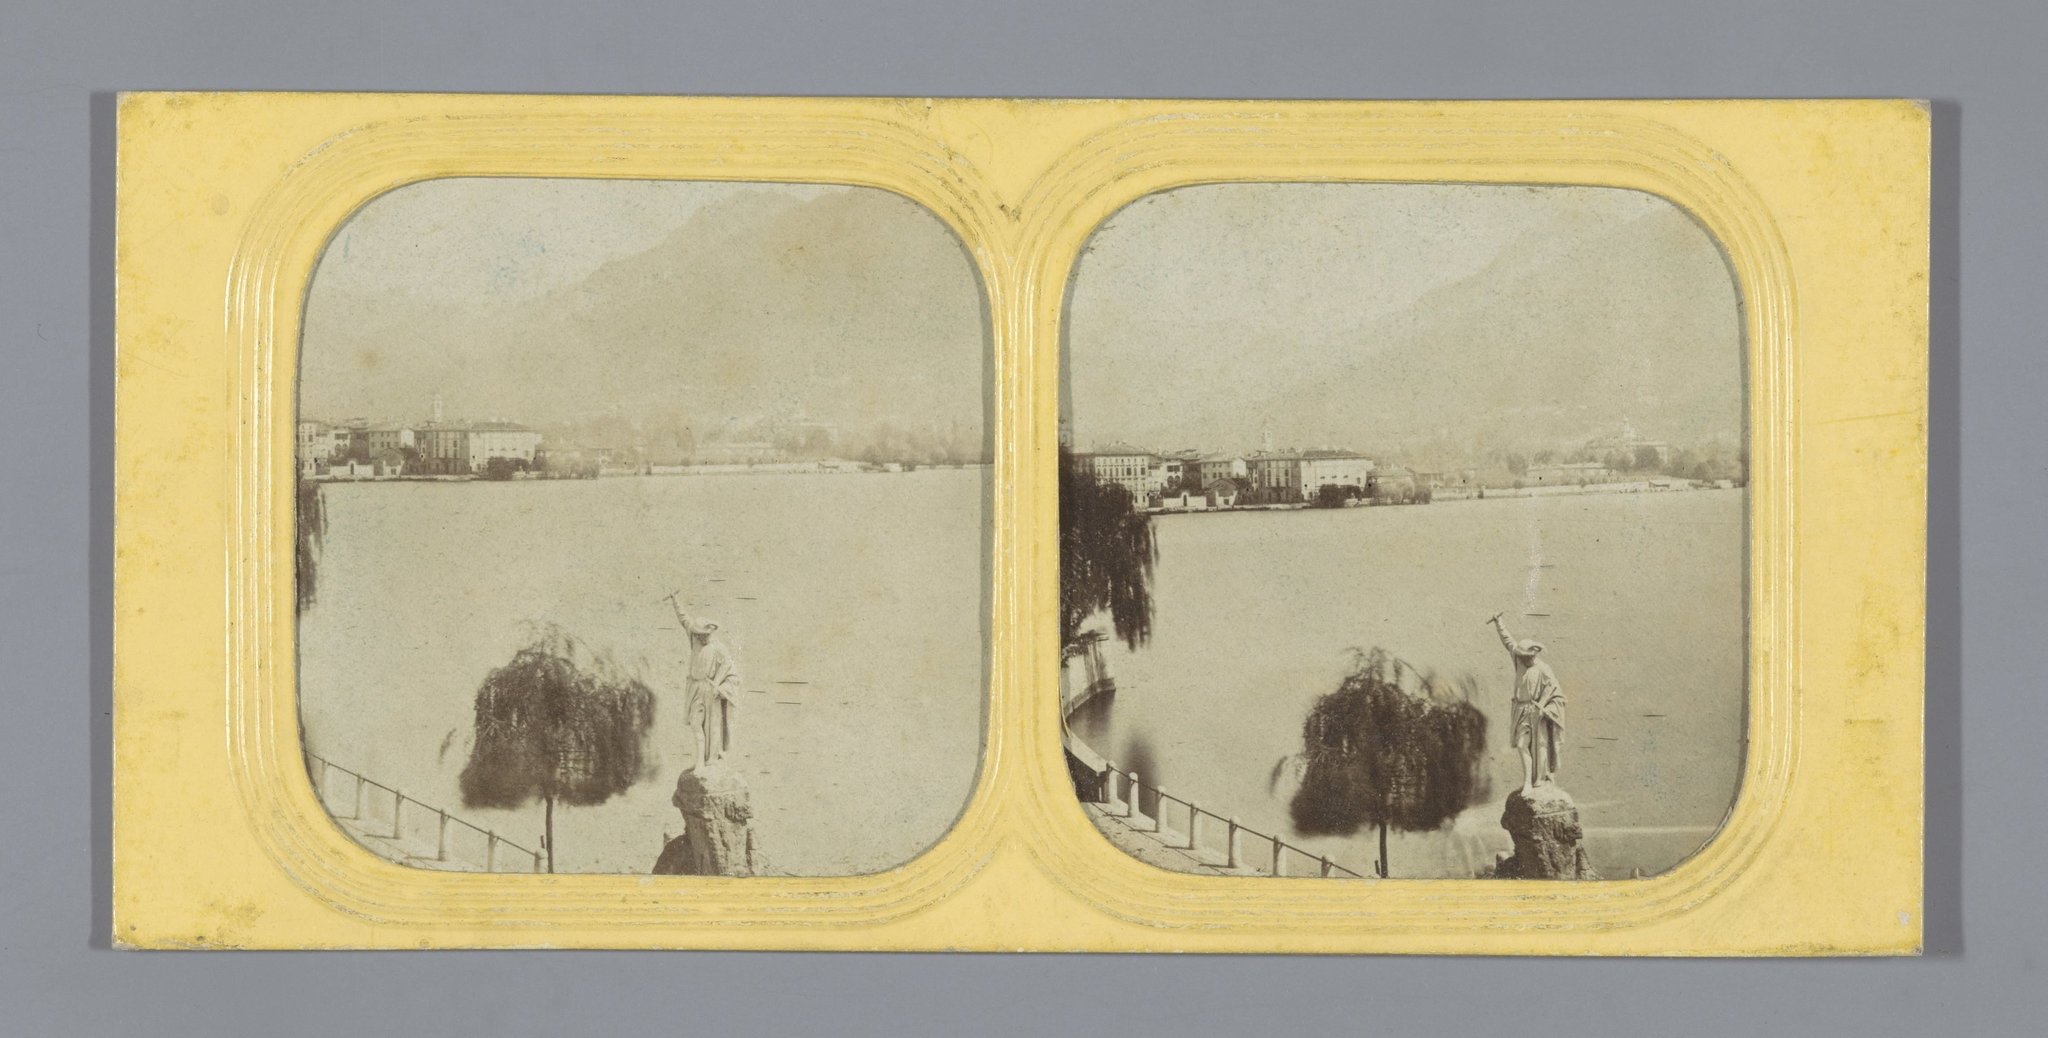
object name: tissue stereograph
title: Gezicht op het meer van Lugano en het standbeeld van Willem Tell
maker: Anonymous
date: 1855-1875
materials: cardboard, paper, photographic support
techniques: albumen print, cutting, hand coloring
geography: lugano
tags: lake, monument, statue